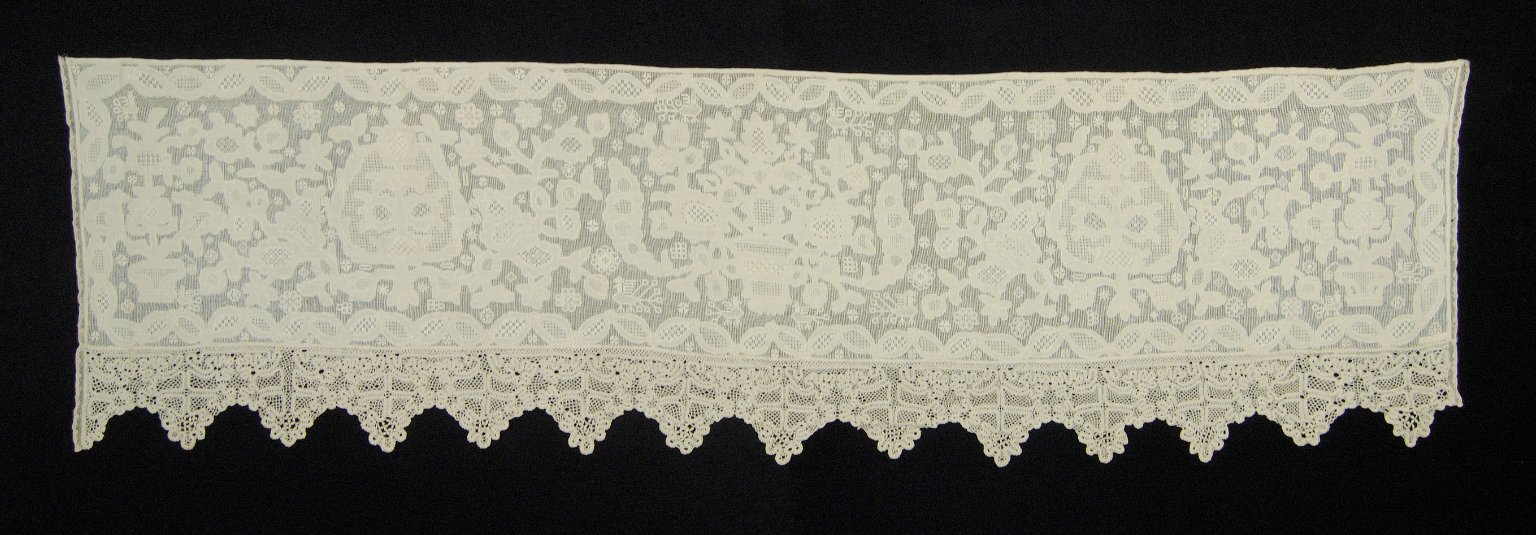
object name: textile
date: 1800-1850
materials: linen